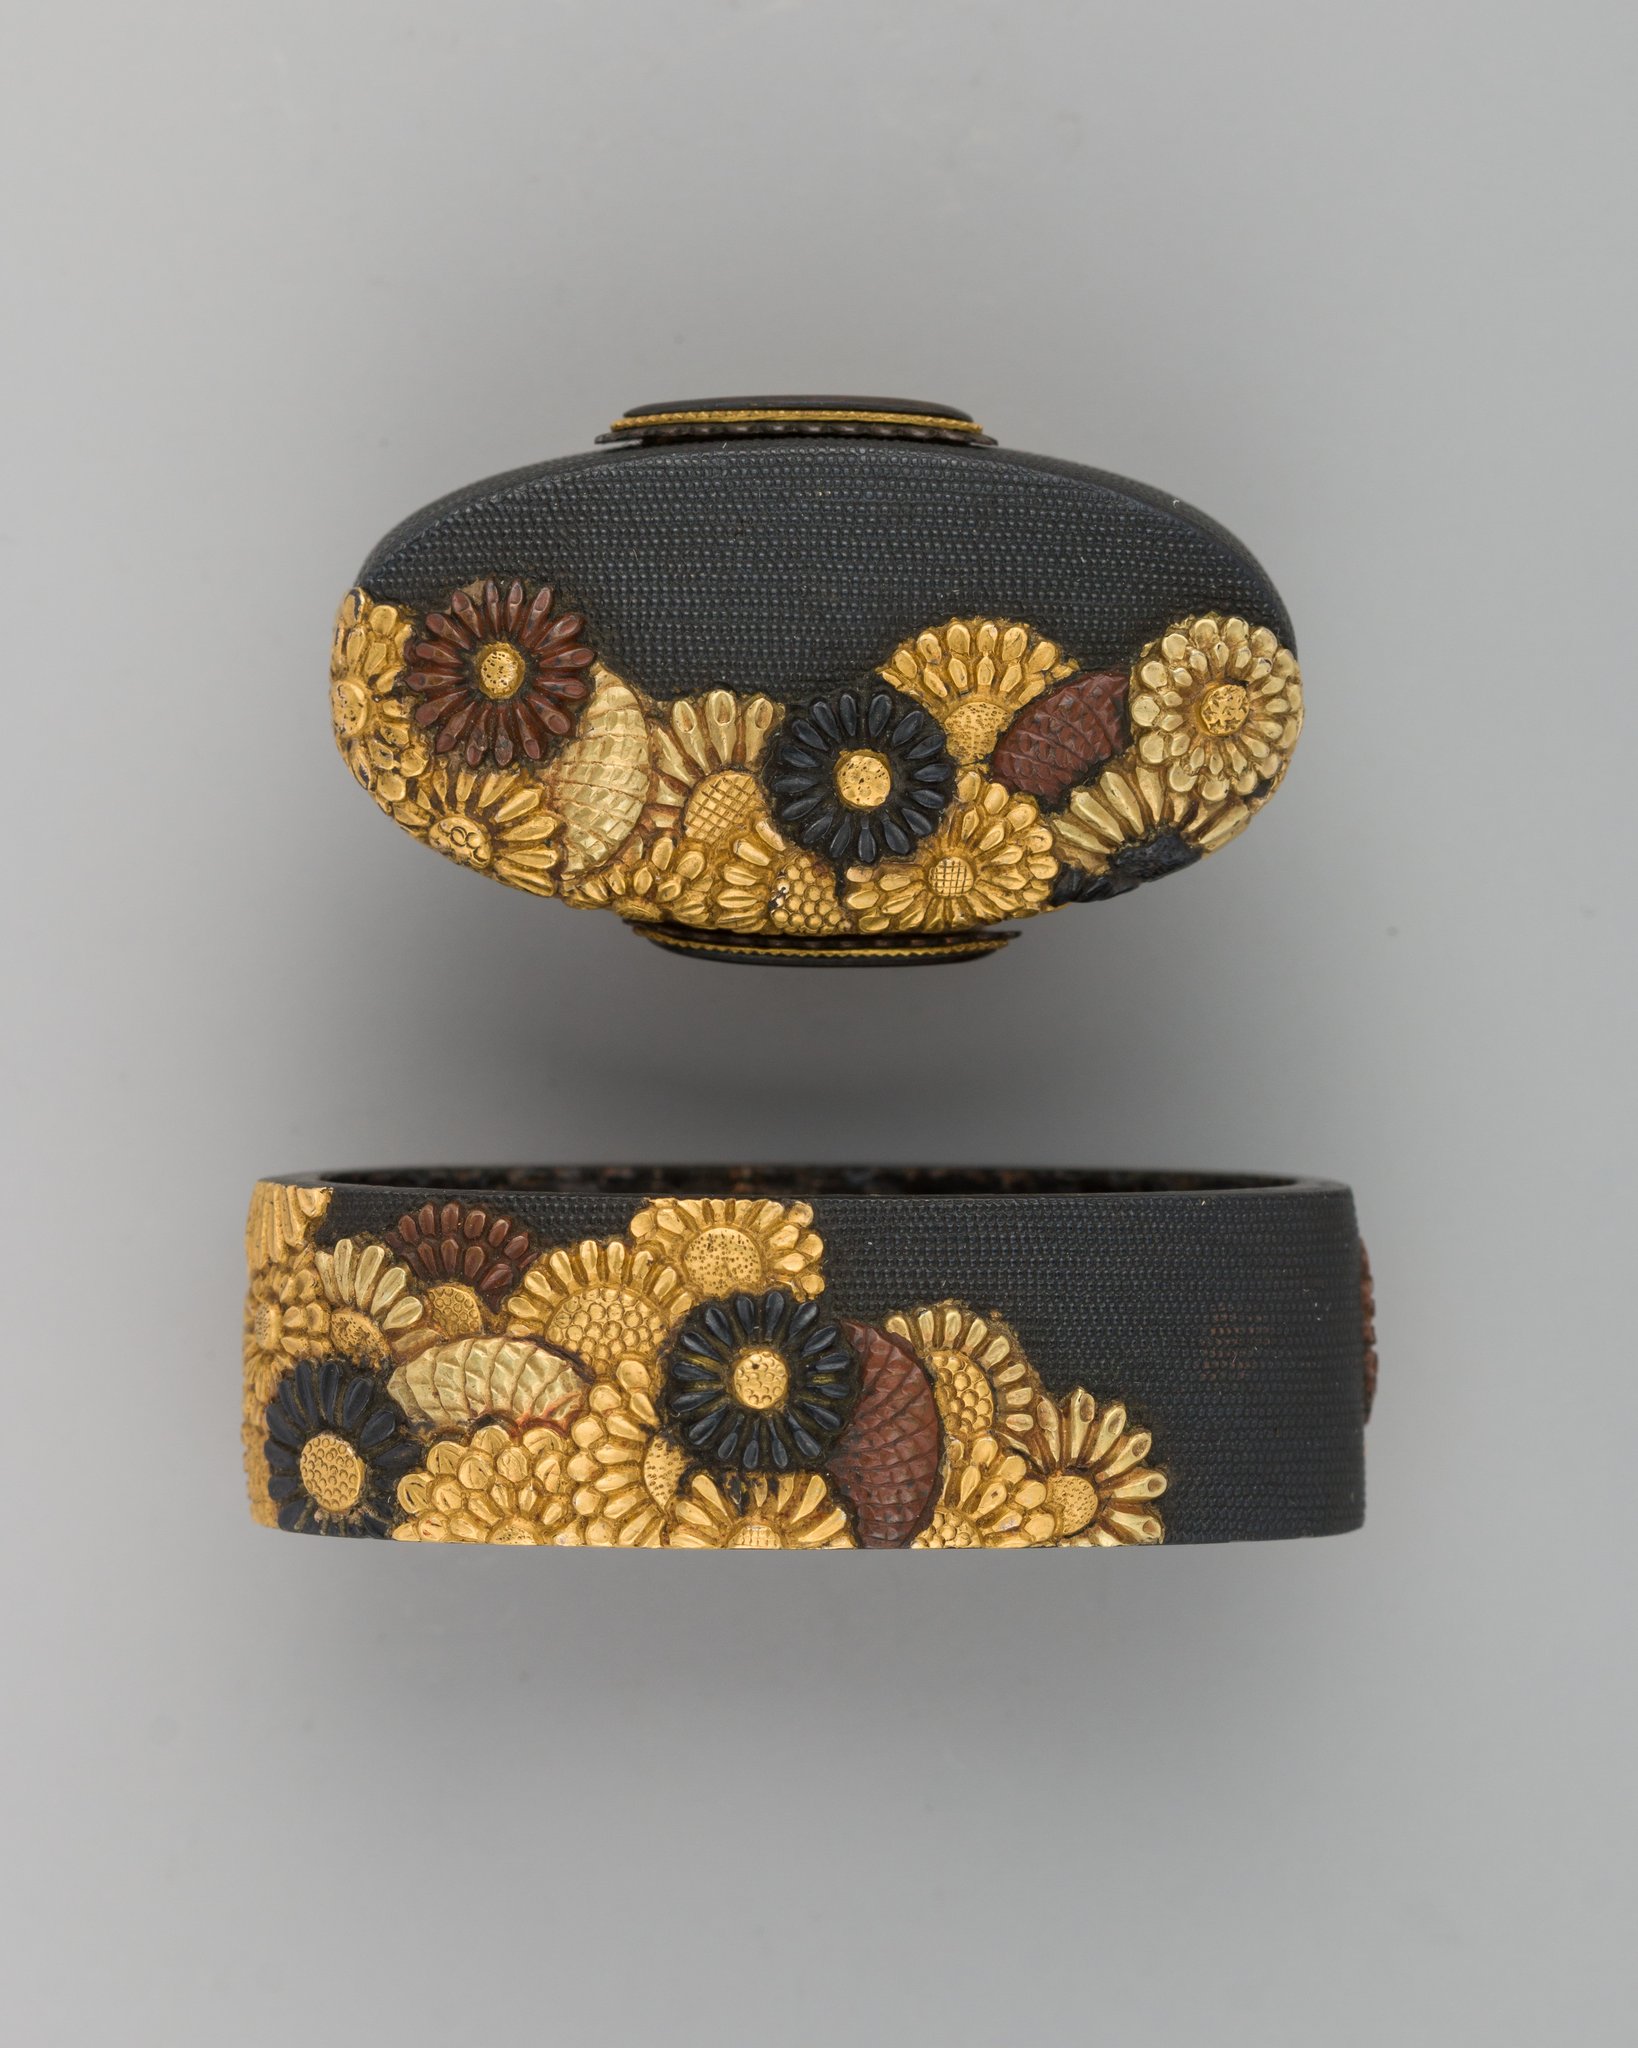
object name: sword hilt collar and pommel fuchigashira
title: Sword-Hilt Collar and Pommel (Fuchigashira)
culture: japanese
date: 1615-1868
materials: copper, gold alloy, gold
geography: japan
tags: flowers